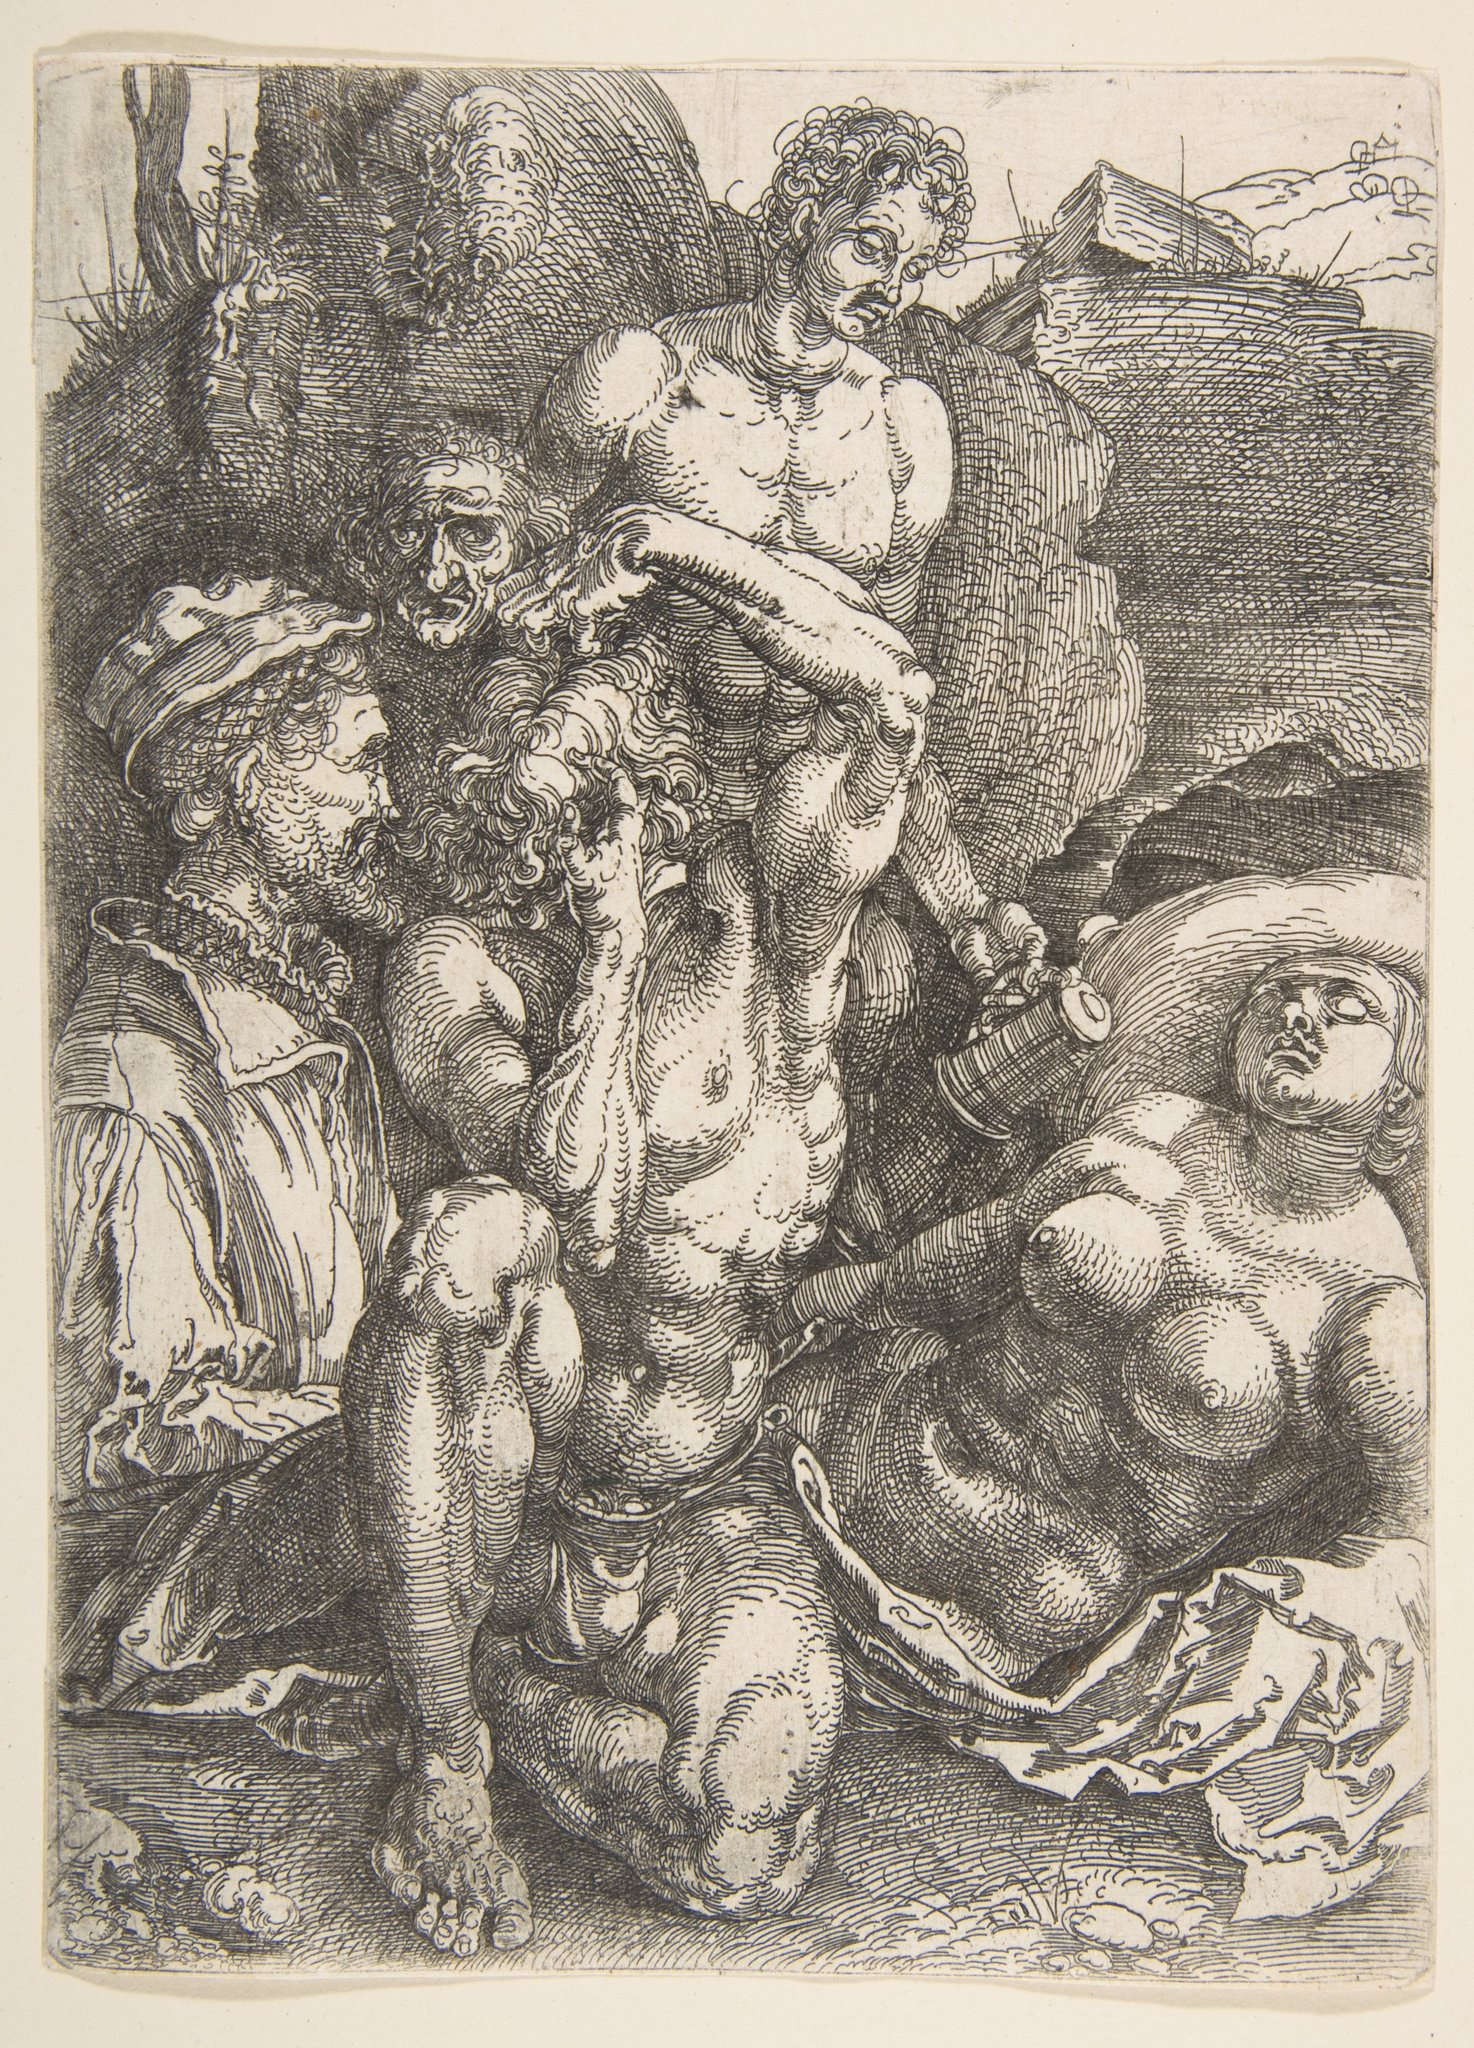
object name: print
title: The Desperate Man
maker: albrecht dürer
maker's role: artist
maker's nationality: german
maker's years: 1471-1528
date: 1515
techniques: etching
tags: men,female nudes